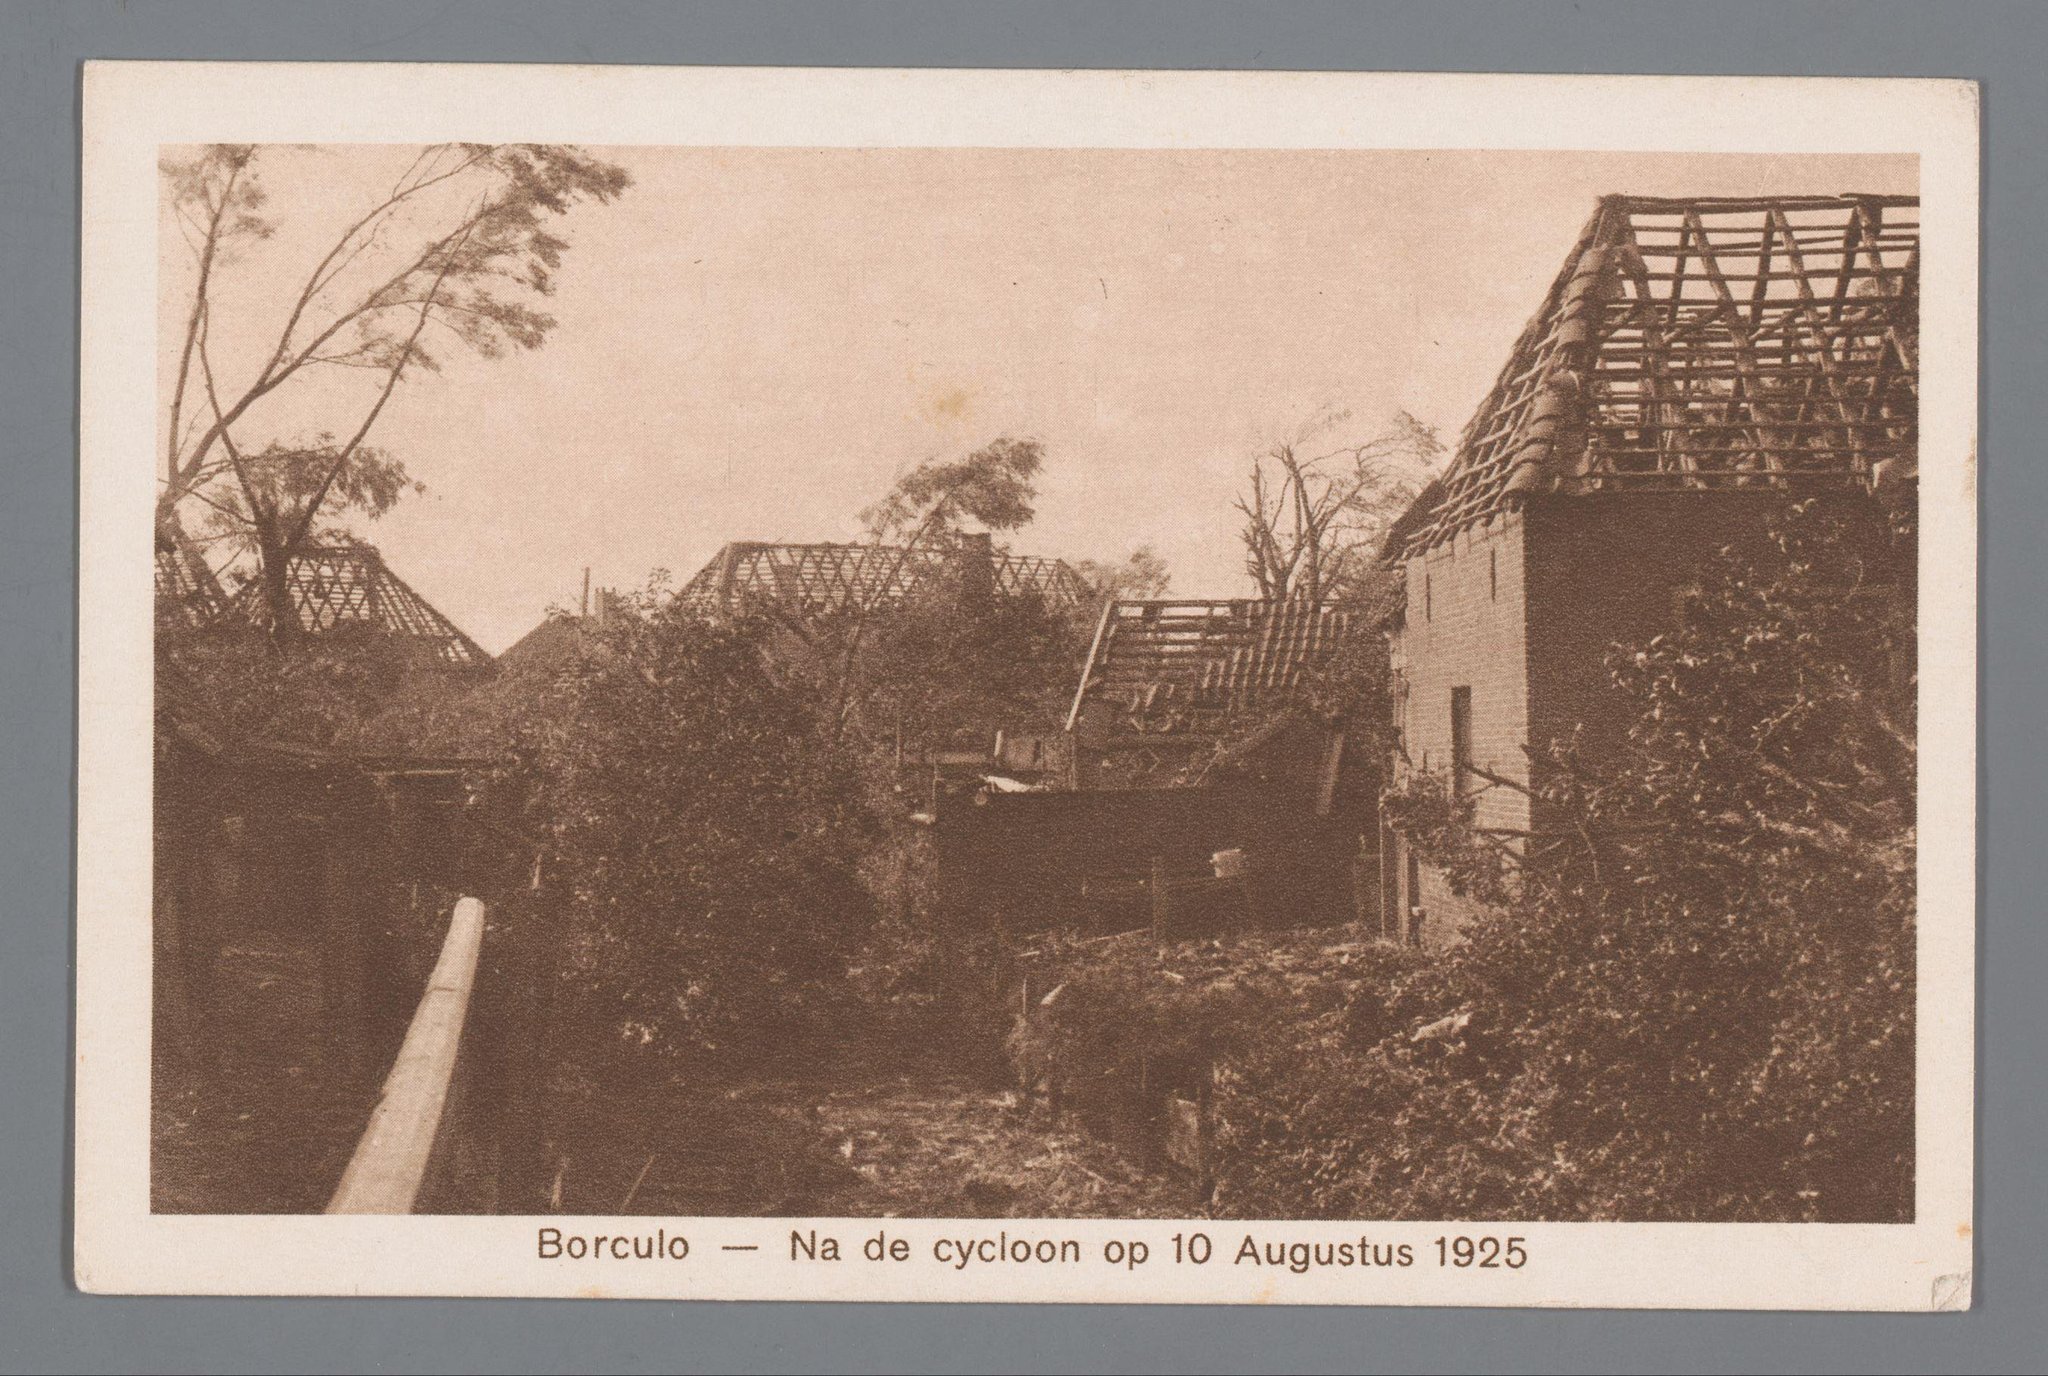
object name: ansichtkaart, prentbriefkaart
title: Borculo -- Na de cycloon op 10 augustus 1925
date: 1925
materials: paper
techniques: photography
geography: the hague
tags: borculo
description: Briefkaart, bruingetint foto van de toestand in Borculo nadat er op 10-08-1925 een cycloon over het dorp was geraasd.